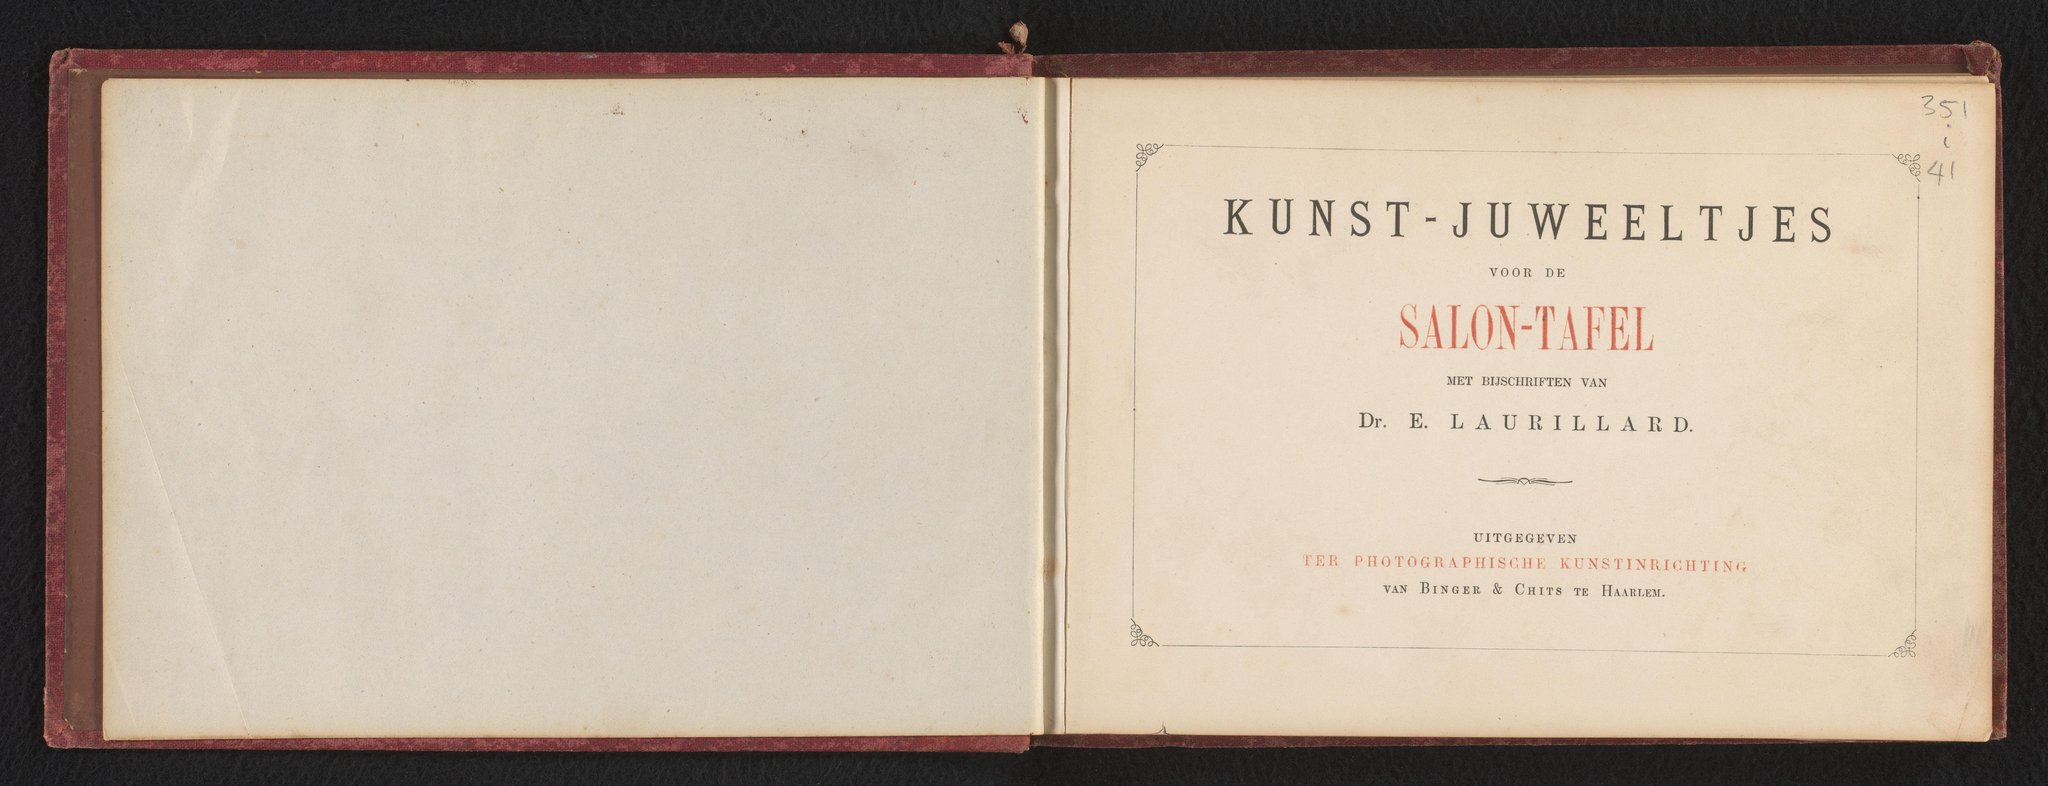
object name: book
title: Kunst-juweeltjes voor de salon-tafel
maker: eliza laurillard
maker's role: dominee, schrijver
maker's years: 1830-1908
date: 1872-1875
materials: cardboard, paper, linen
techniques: albumen print, letterpress printing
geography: haarlem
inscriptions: inscription: ‘mH[?]’